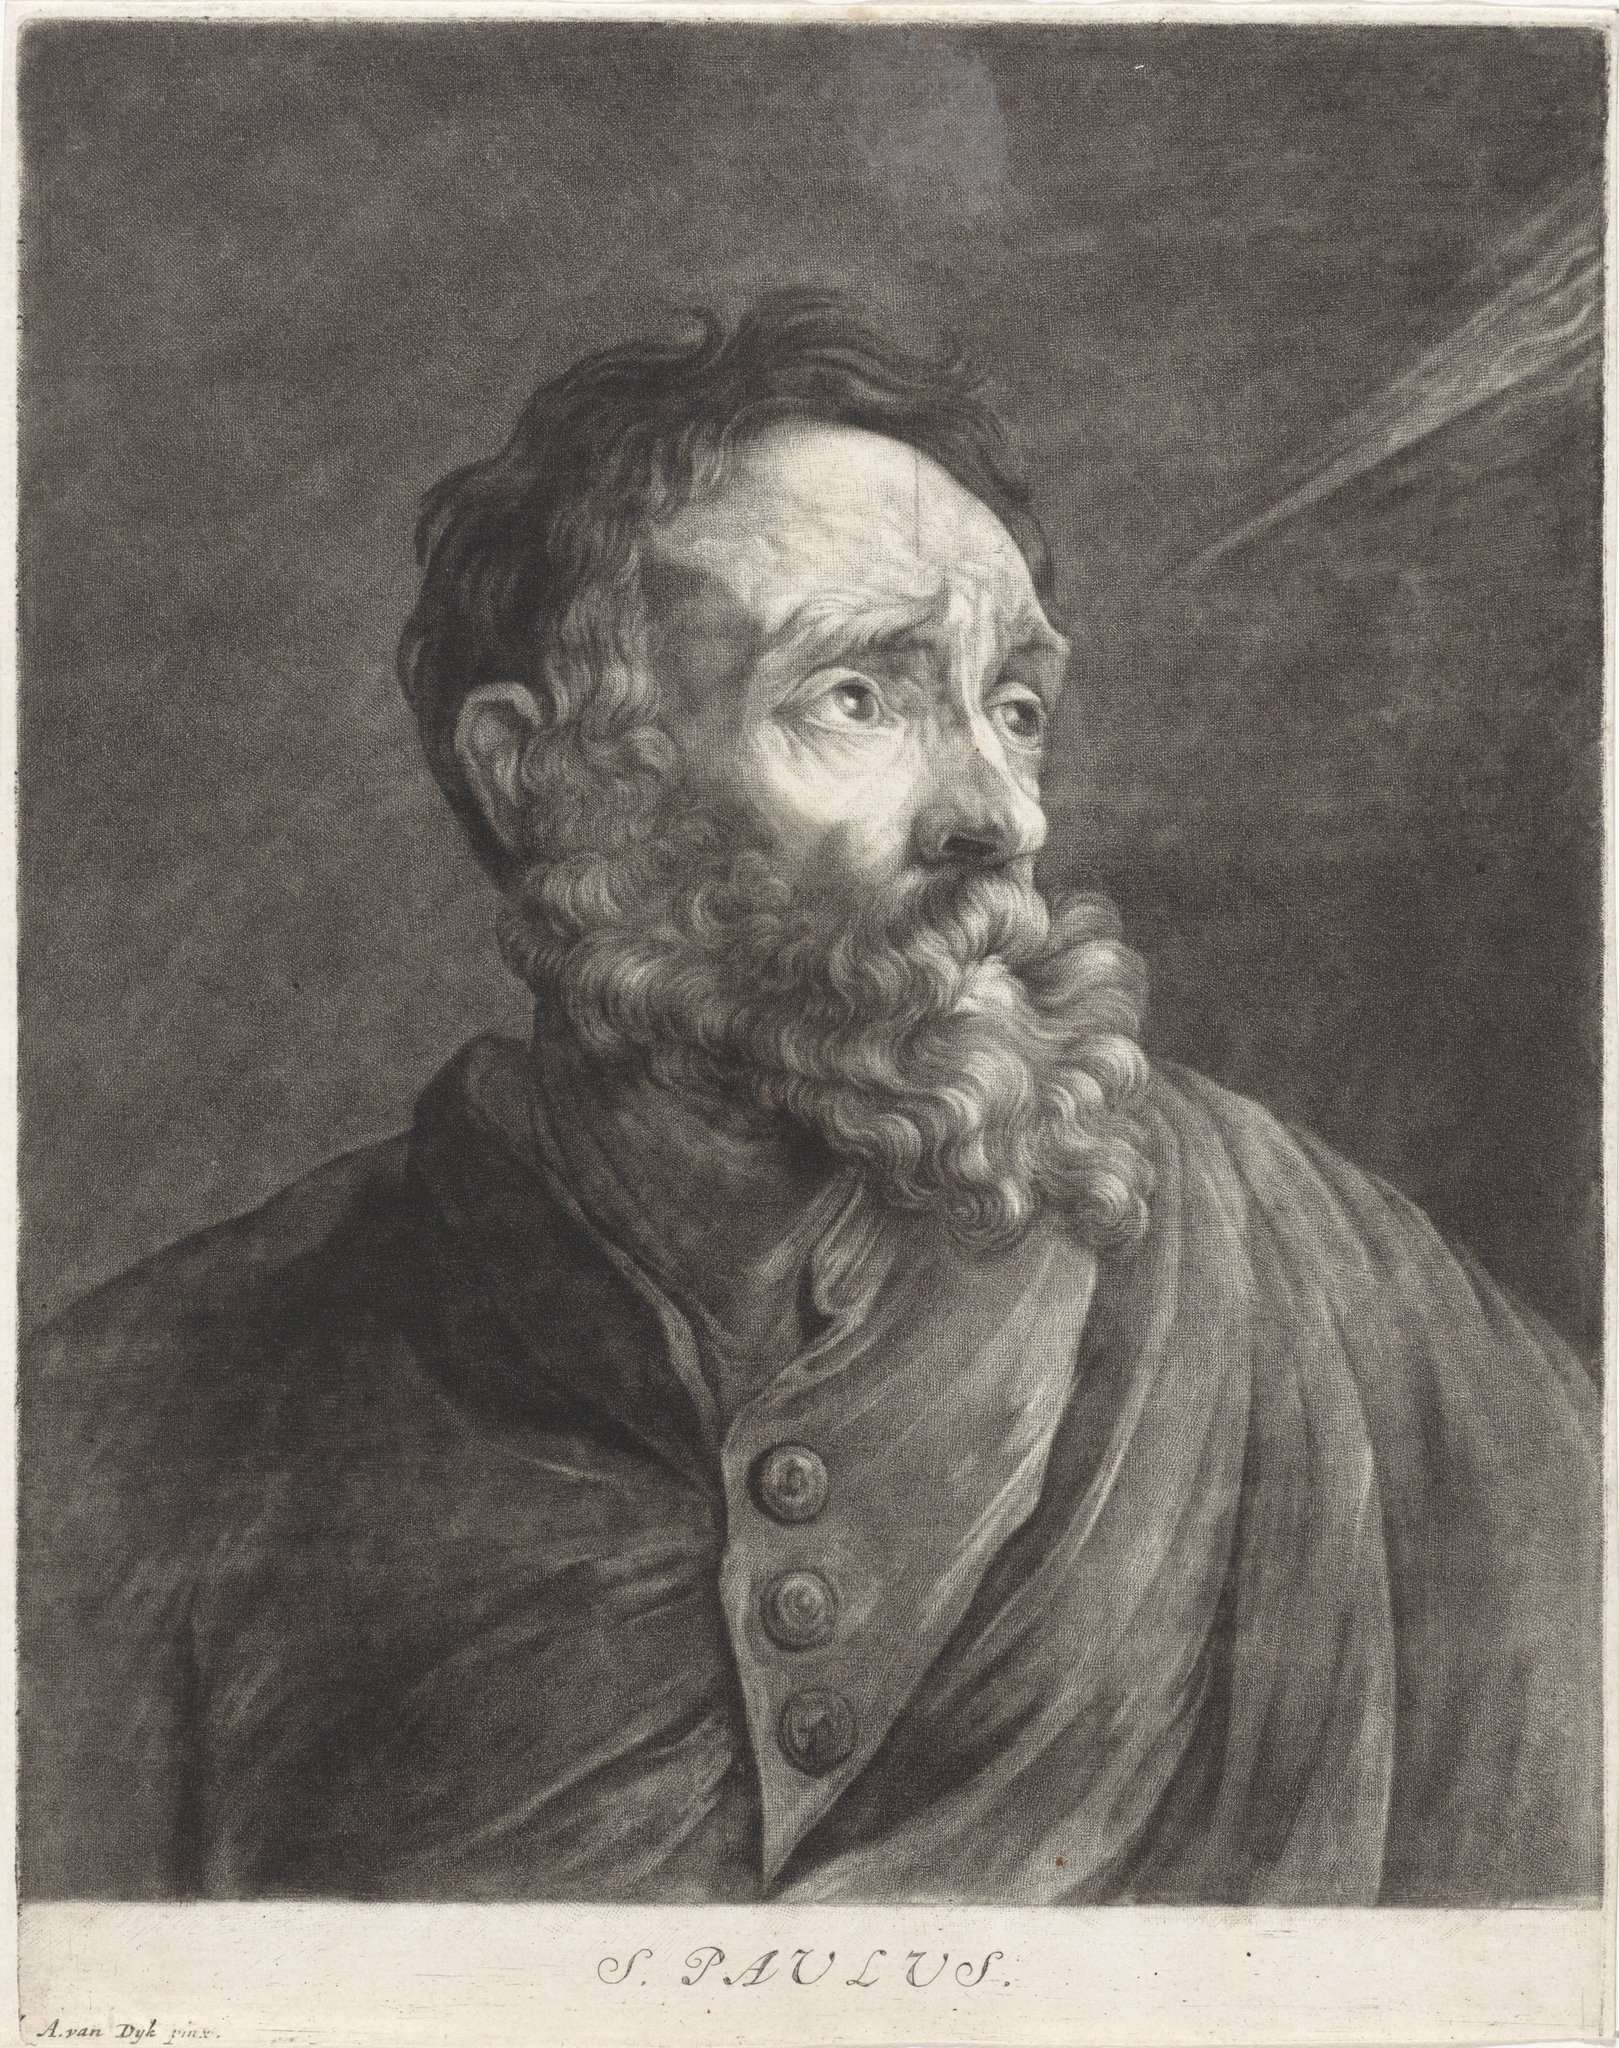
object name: print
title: Apostel Paulus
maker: Anonymous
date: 1652-1740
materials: paper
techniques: engraving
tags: the apostle paul of tarsus; possible attributes: book, scroll, sword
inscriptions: collector's mark: Lugt 2228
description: Deze prent is een kopie naar een gelijknamige prent van Abraham Bloteling.